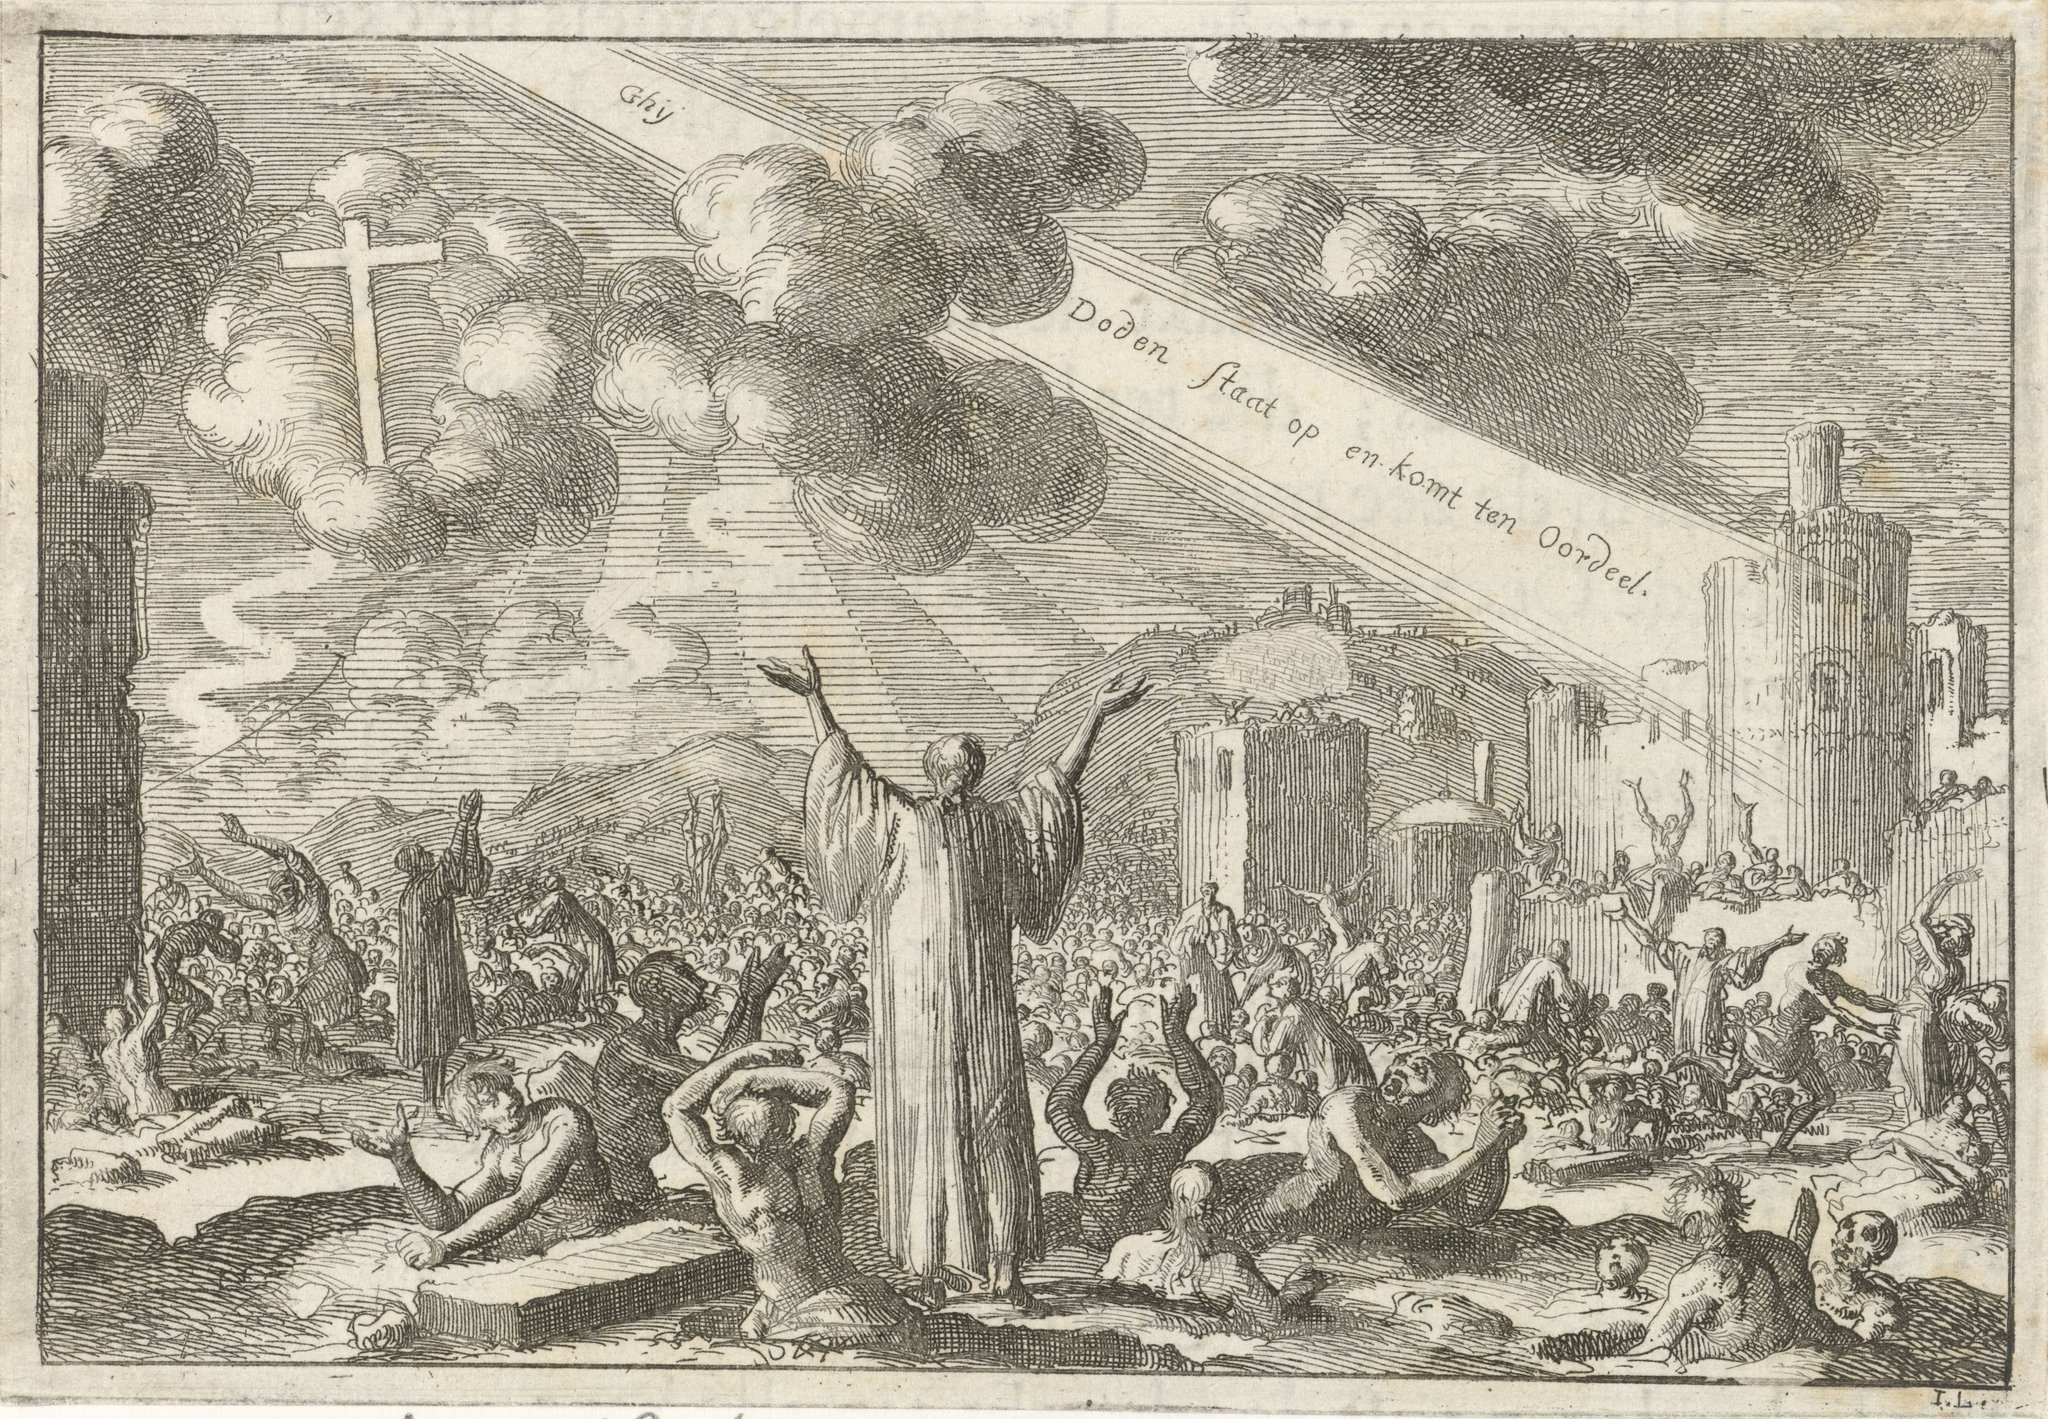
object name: book illustration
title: Opstanding van de doden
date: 1687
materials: paper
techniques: etching, letterpress printing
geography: amsterdam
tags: resurrection of the dead ~ last judgement, 'carnis resurrectionem' ~ articles of faith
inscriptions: collector's mark: Lugt 2228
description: Op aarde staan de doden op uit hun graven om verdeeld te worden tussen engelen en duivels die hen verder leiden.